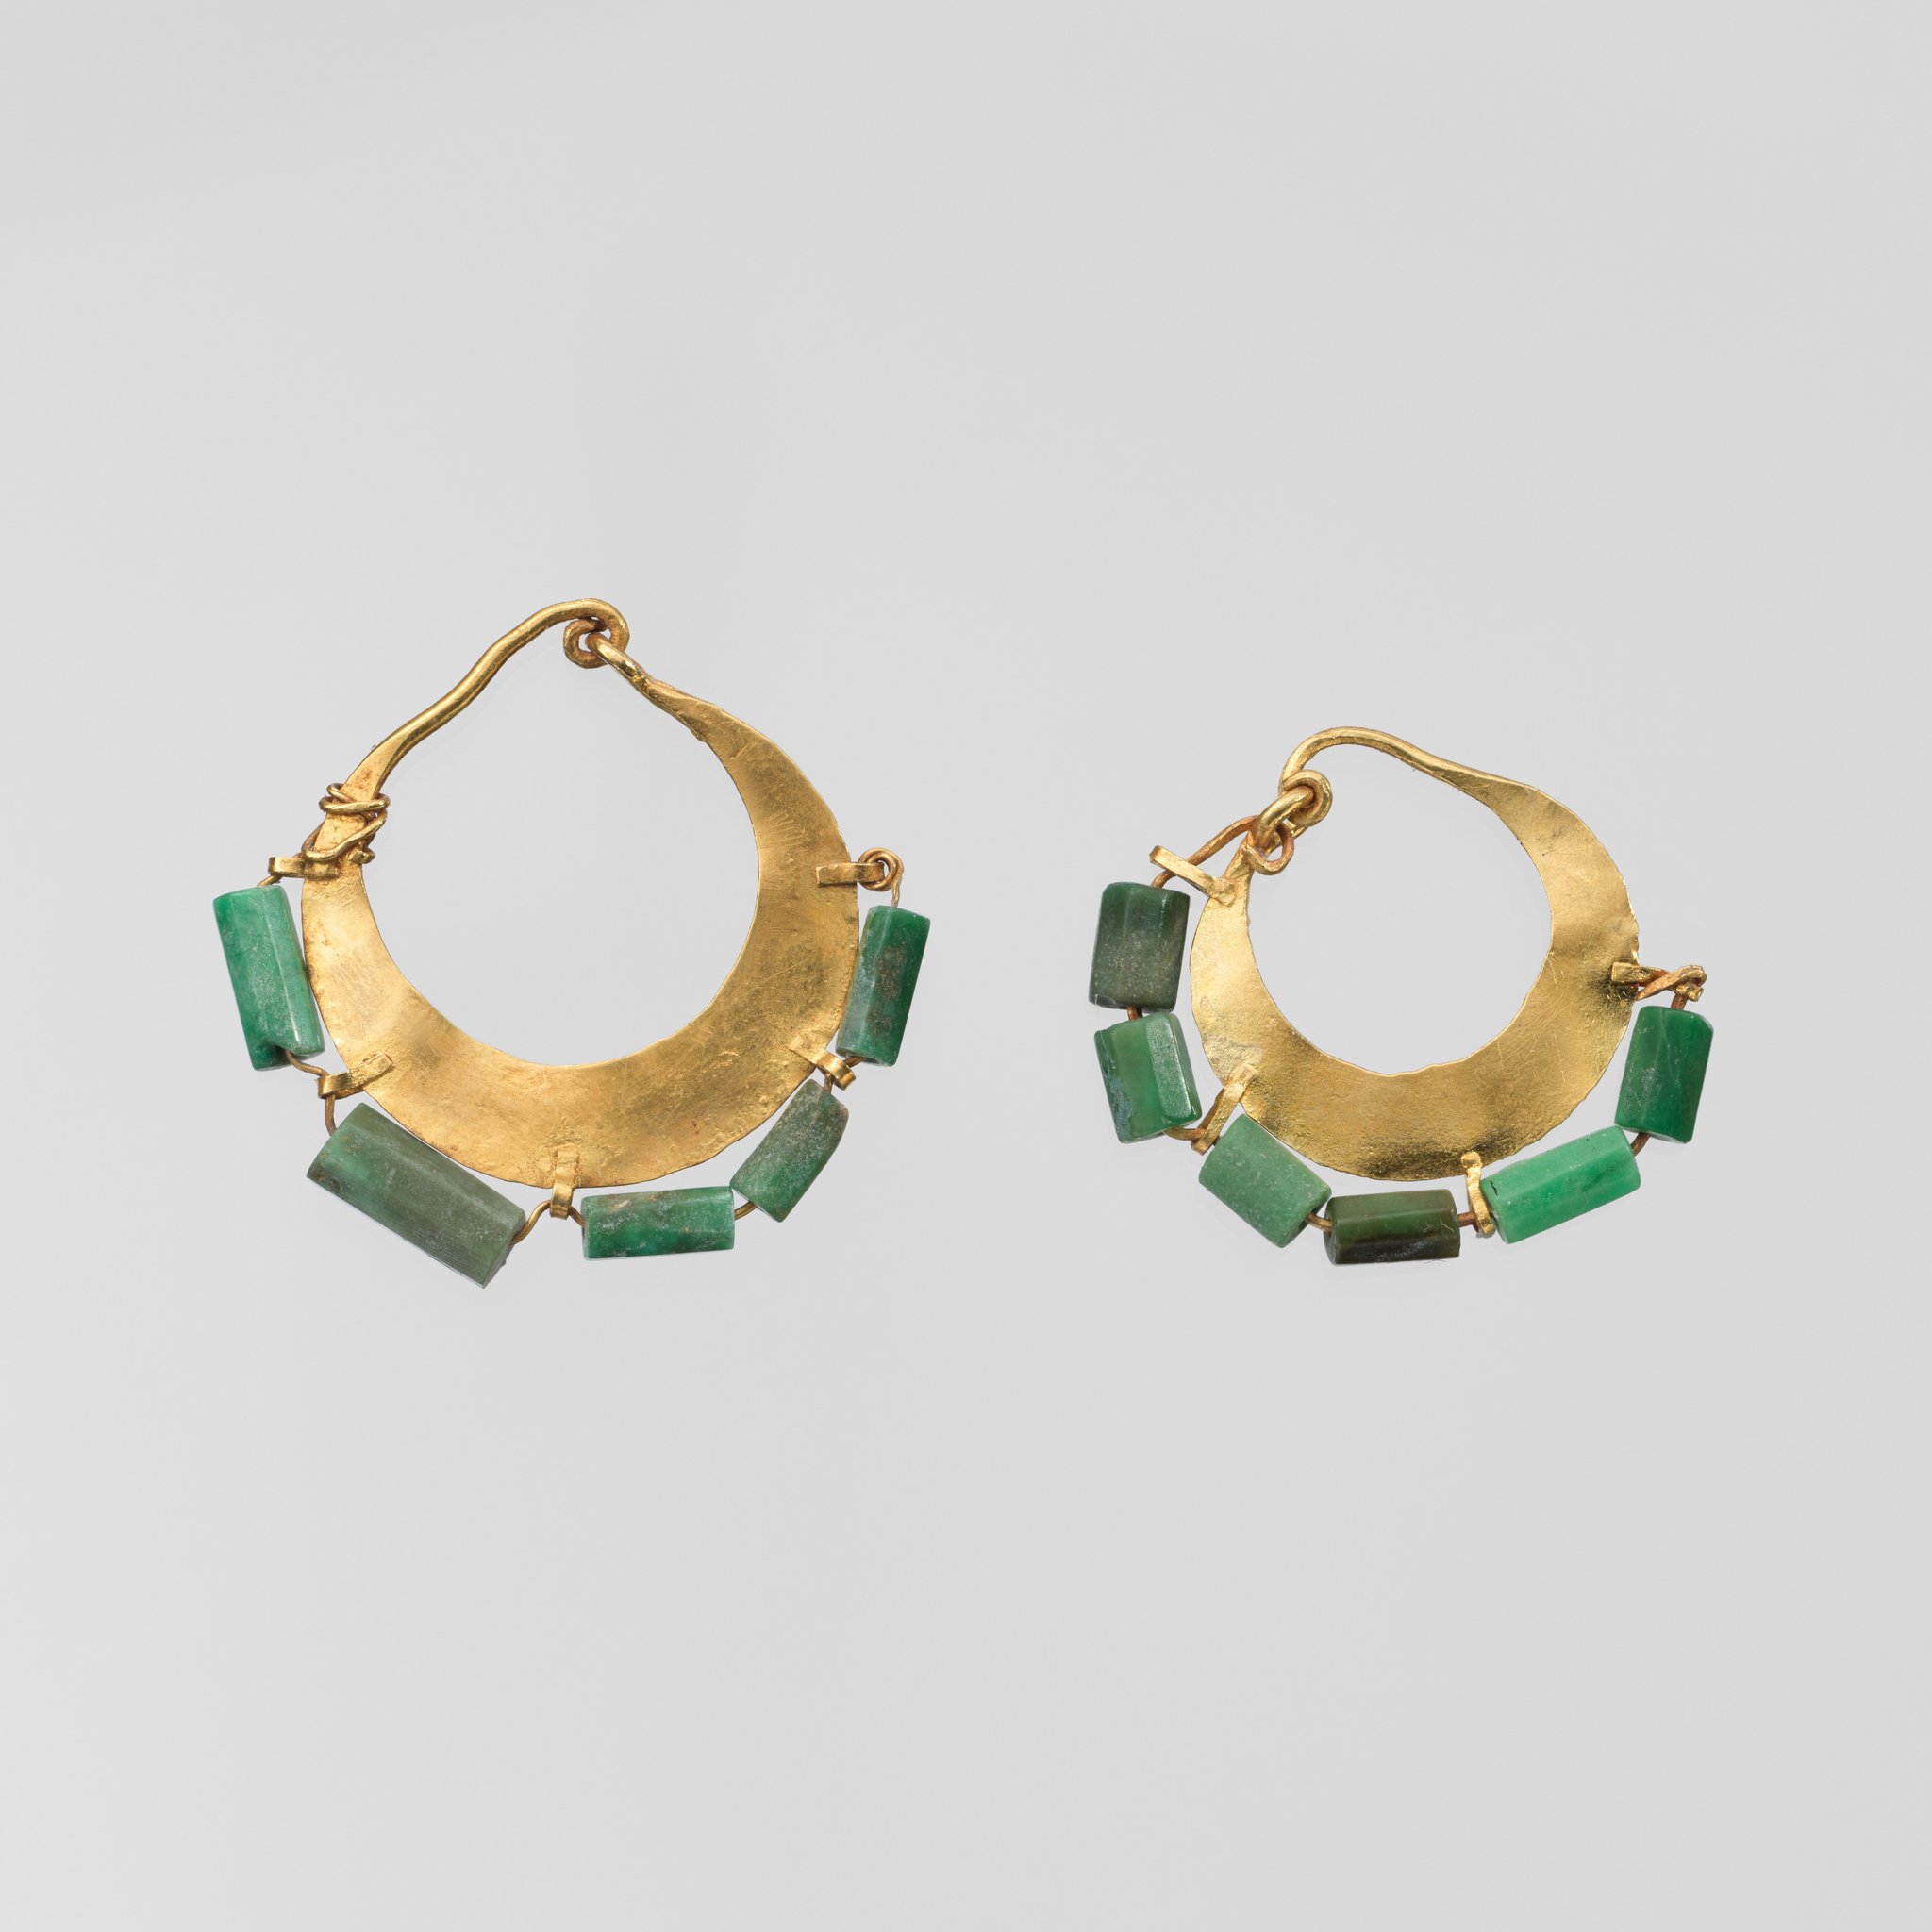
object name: earring, crescent shaped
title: Gold and variscite earring (one of a pair)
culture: roman, cypriot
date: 101-200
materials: stone, gold